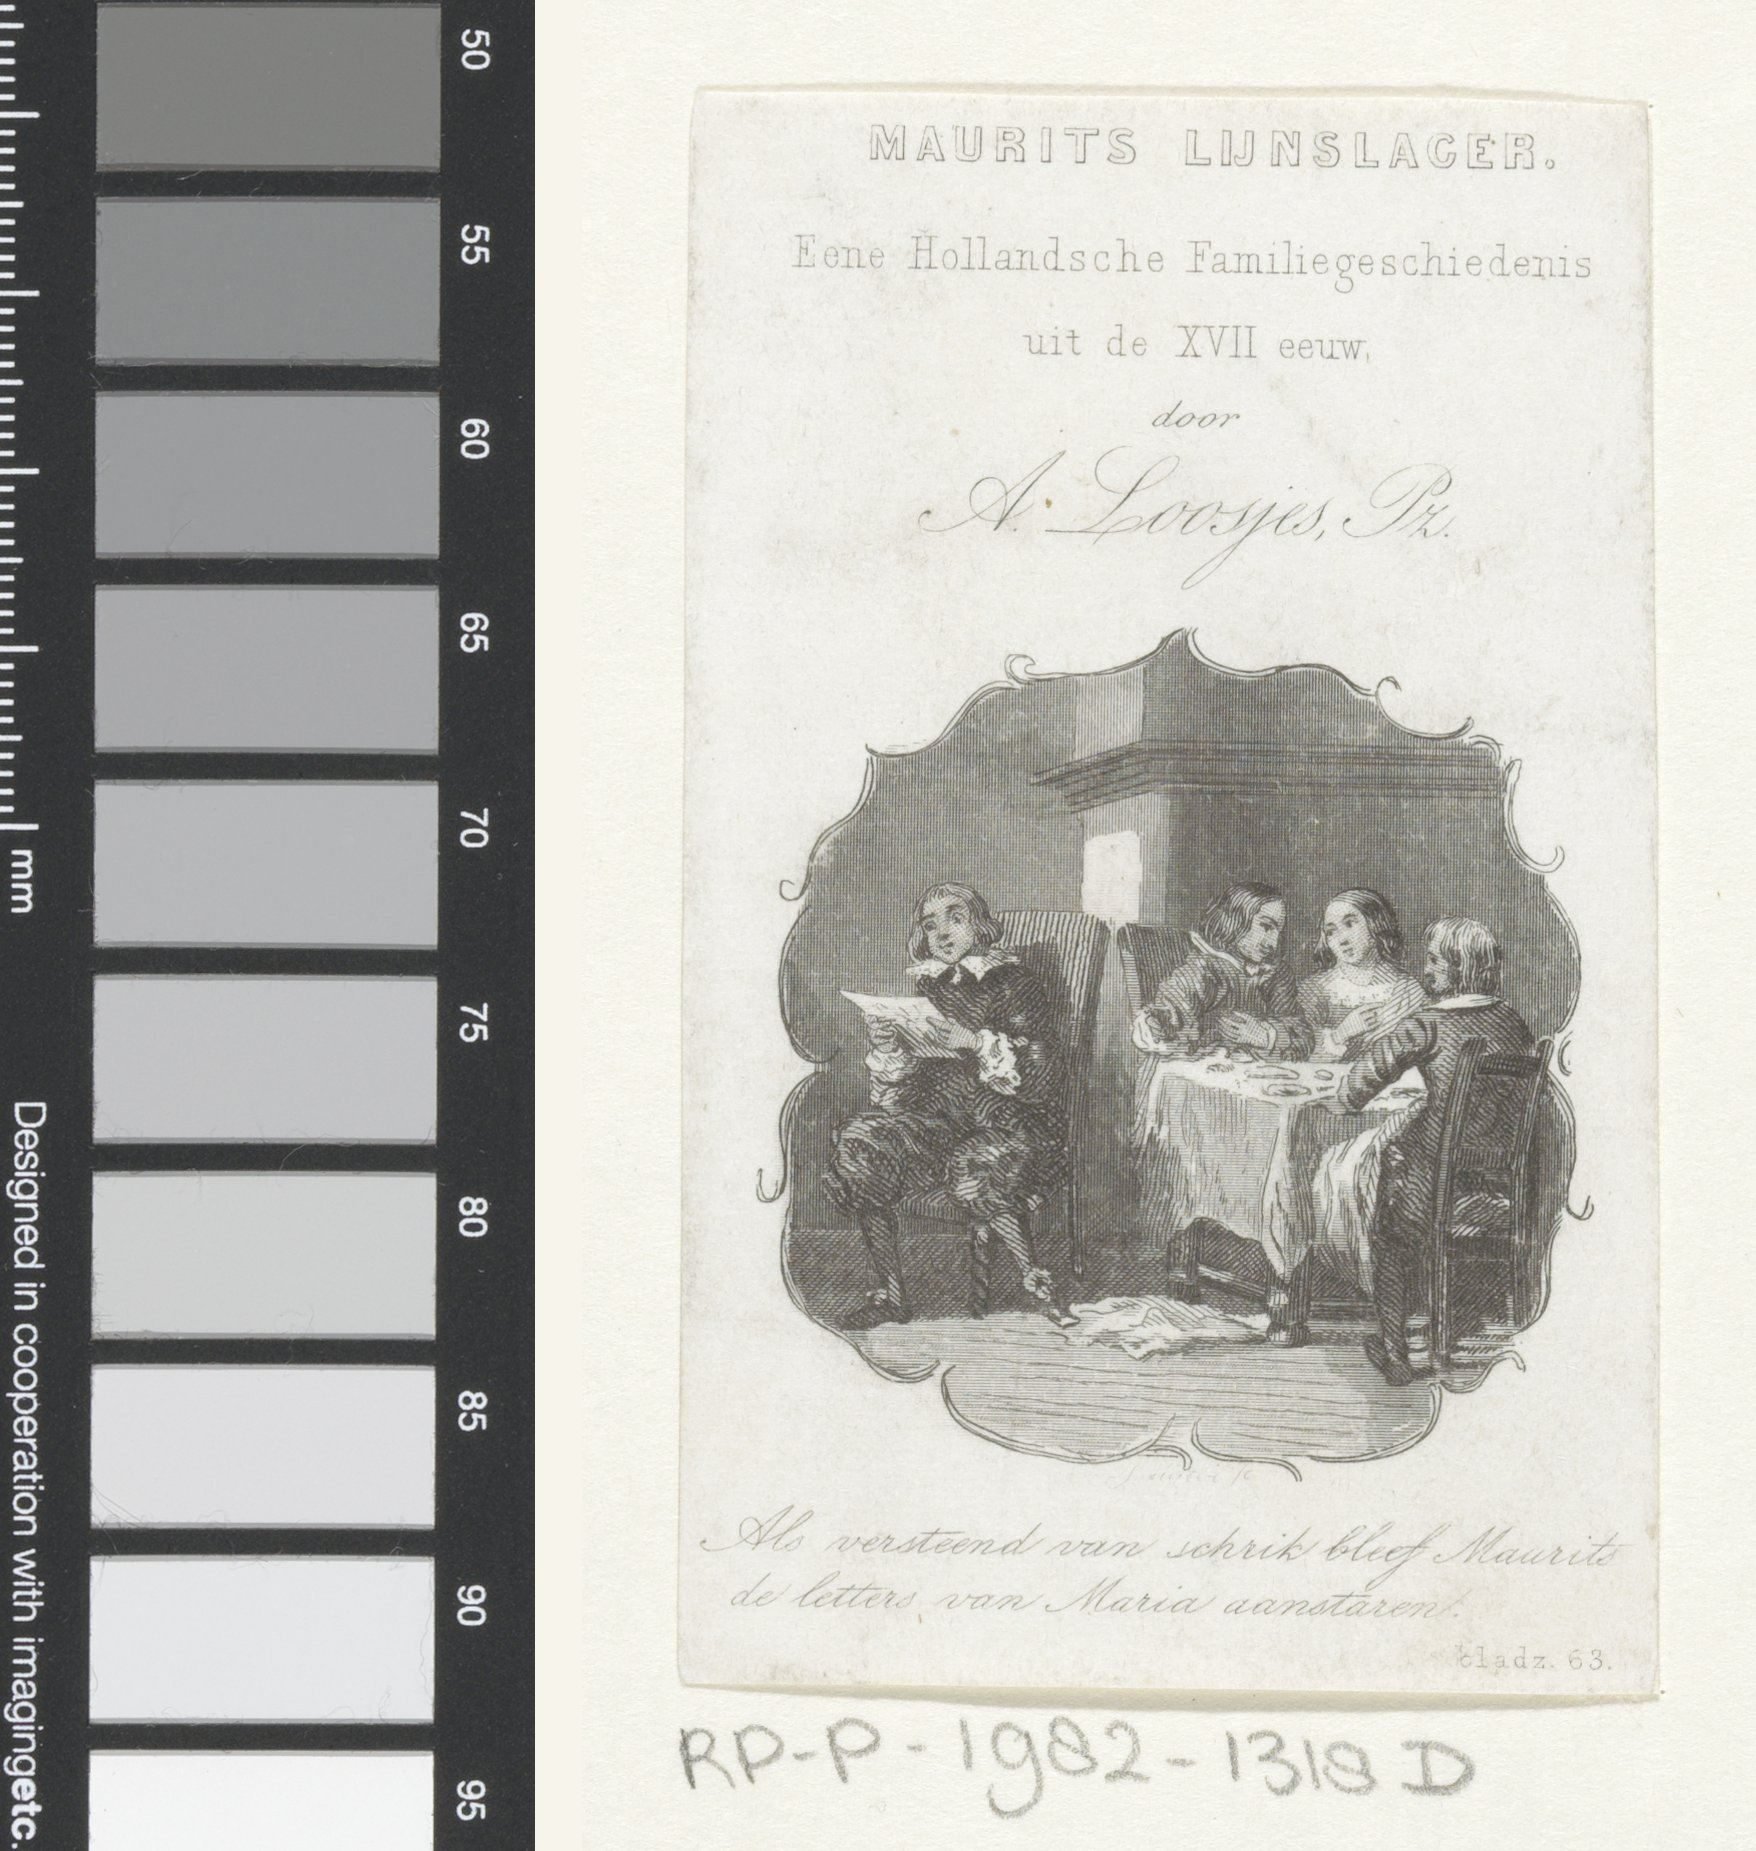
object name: titelblad, titelpagina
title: Titelpagina voor: Adriaen Loosjes Pz, Maurits Lijnslager, Eene Hollandsche Familiegeschiedenis uit de XVII eeuw, 1852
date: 1852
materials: paper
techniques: engraving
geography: haarlem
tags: reading, conversation, dialogue; conversation piece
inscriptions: collector's mark: Lugt 2760, collector's mark: Lugt 2228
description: Titelpagina voor: Loosjes Pz, Adriaen. Maurits Lijnslager, Eene Hollandsche Familiegeschiedenis uit de XVII eeuw. Haarlem: Kruseman, Arie Cornelis, 1852.